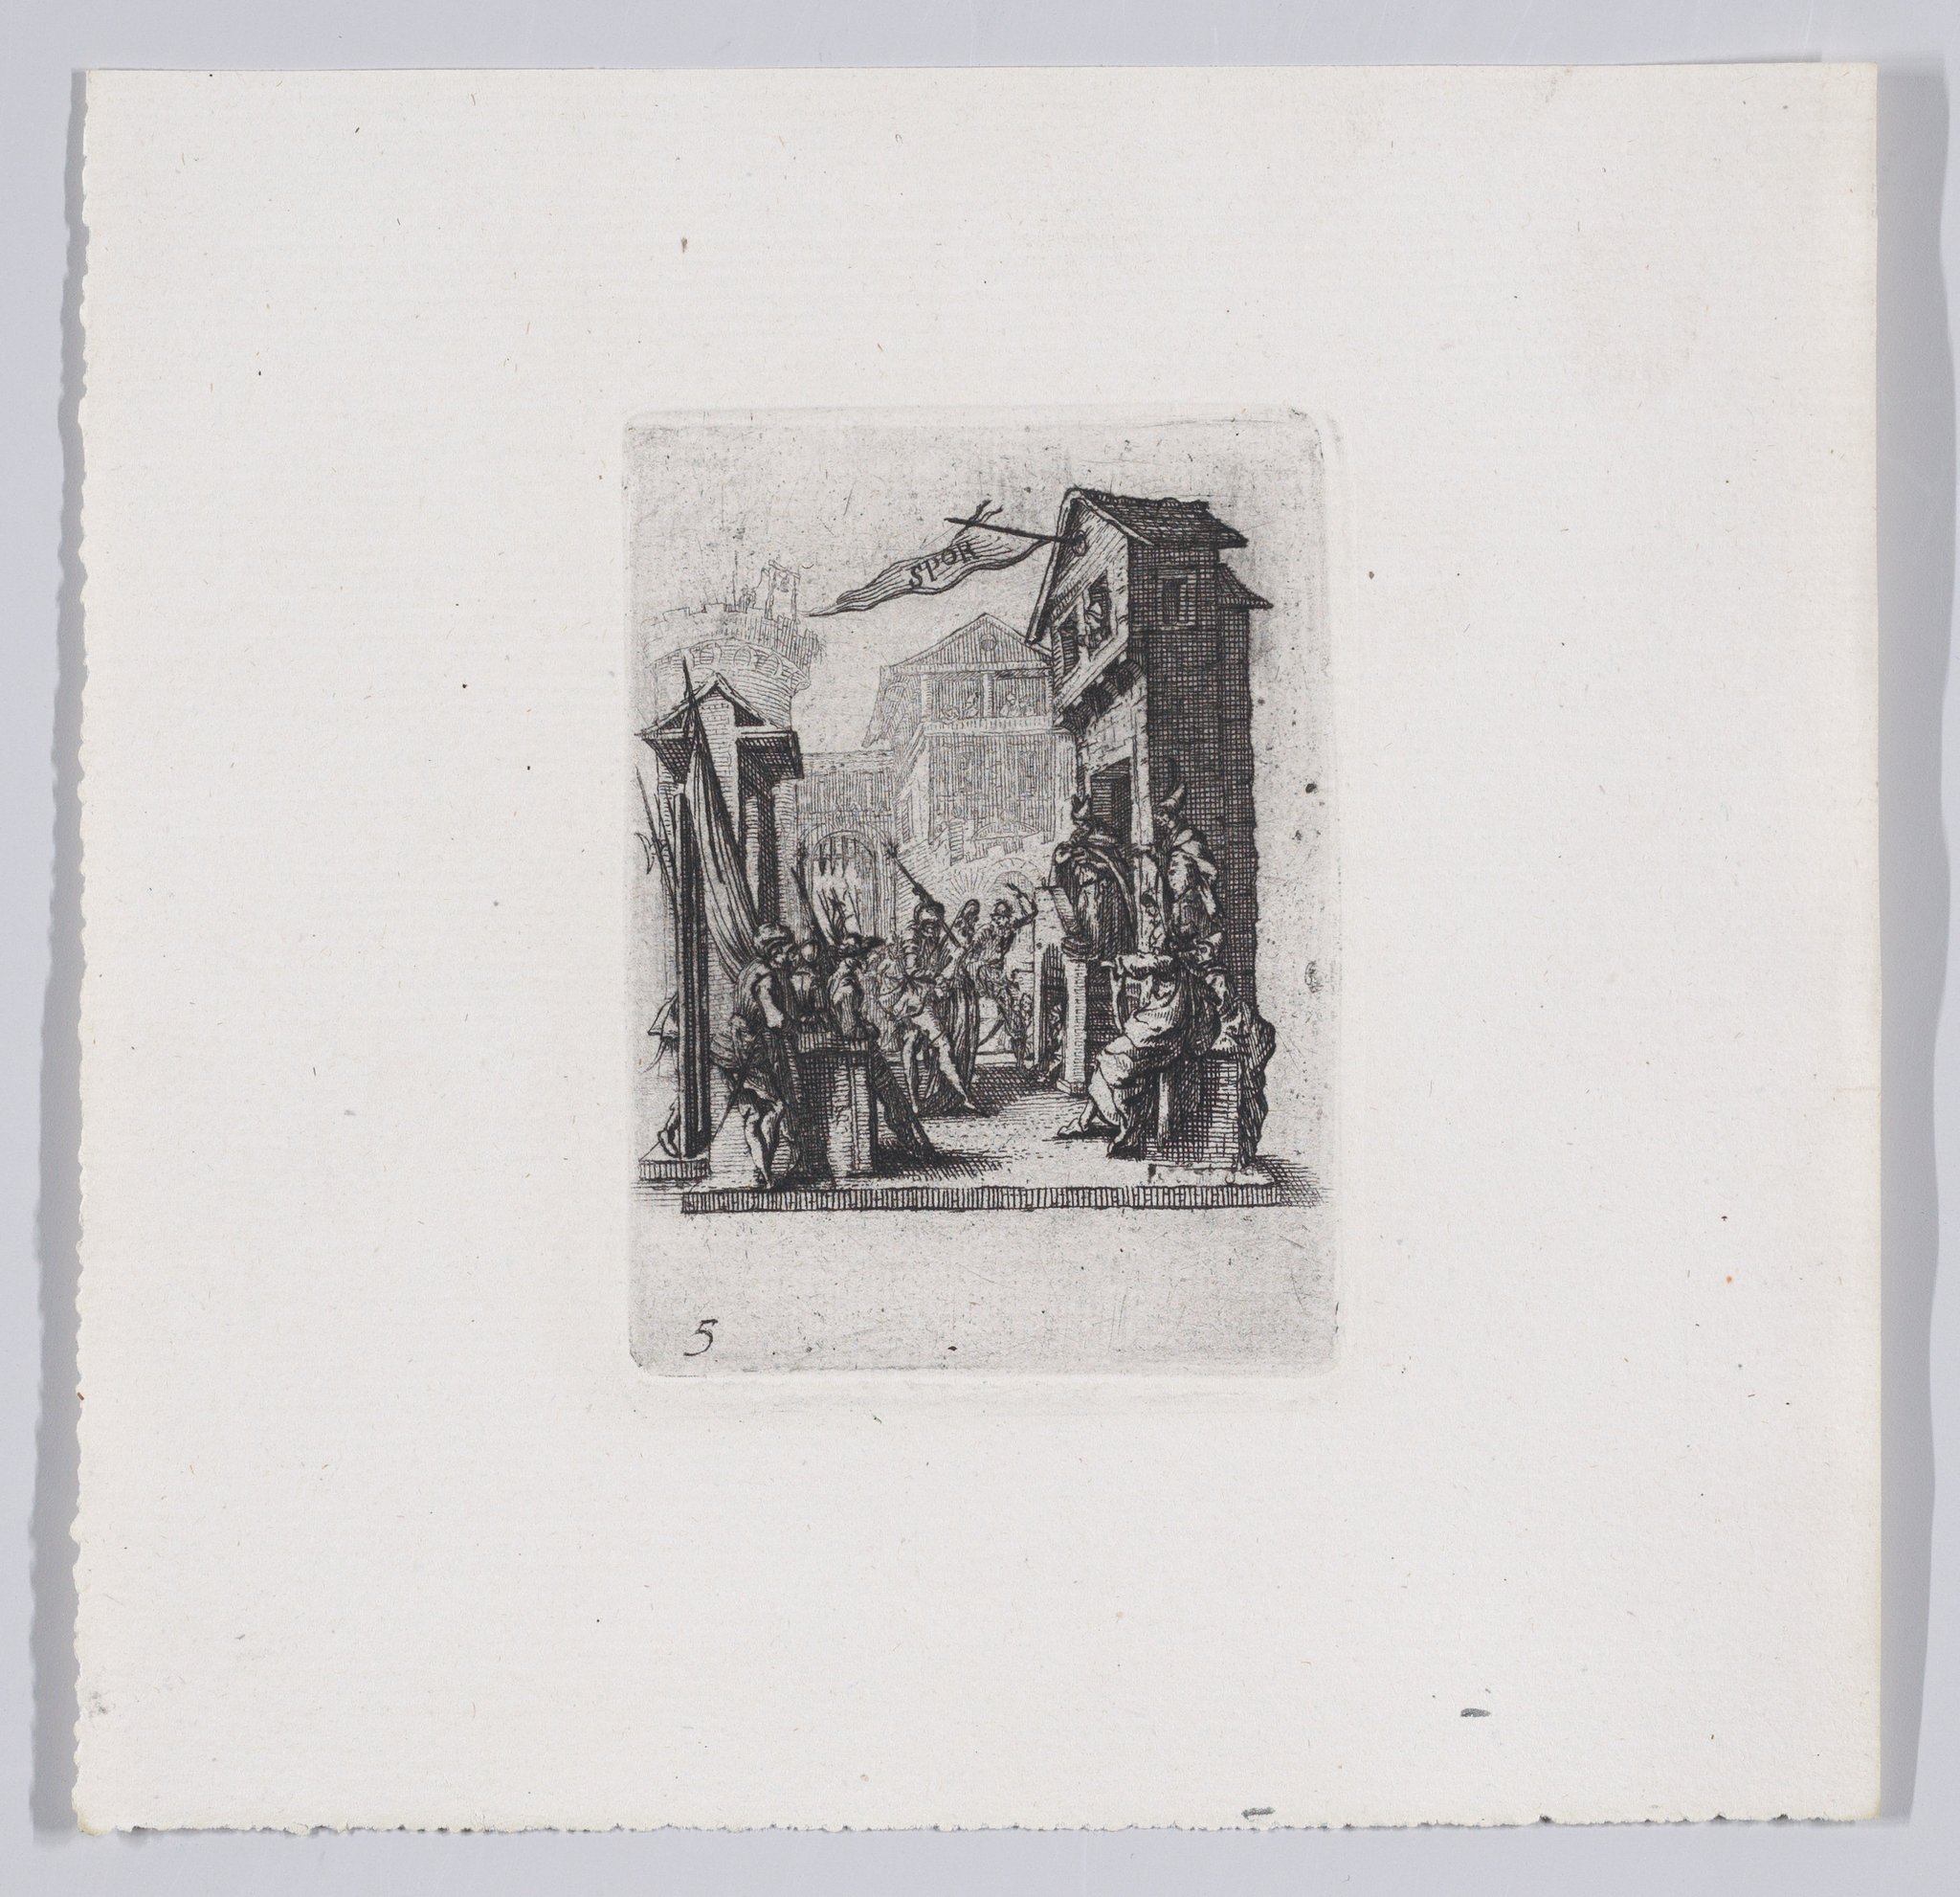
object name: print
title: Reverse Copy of Jésus Comparait Devant Caiphe (Jesus Appears Before Caiaphas), from La Petite Passion (The Little Passion)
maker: Anonymous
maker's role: artist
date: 1601-1700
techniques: etching